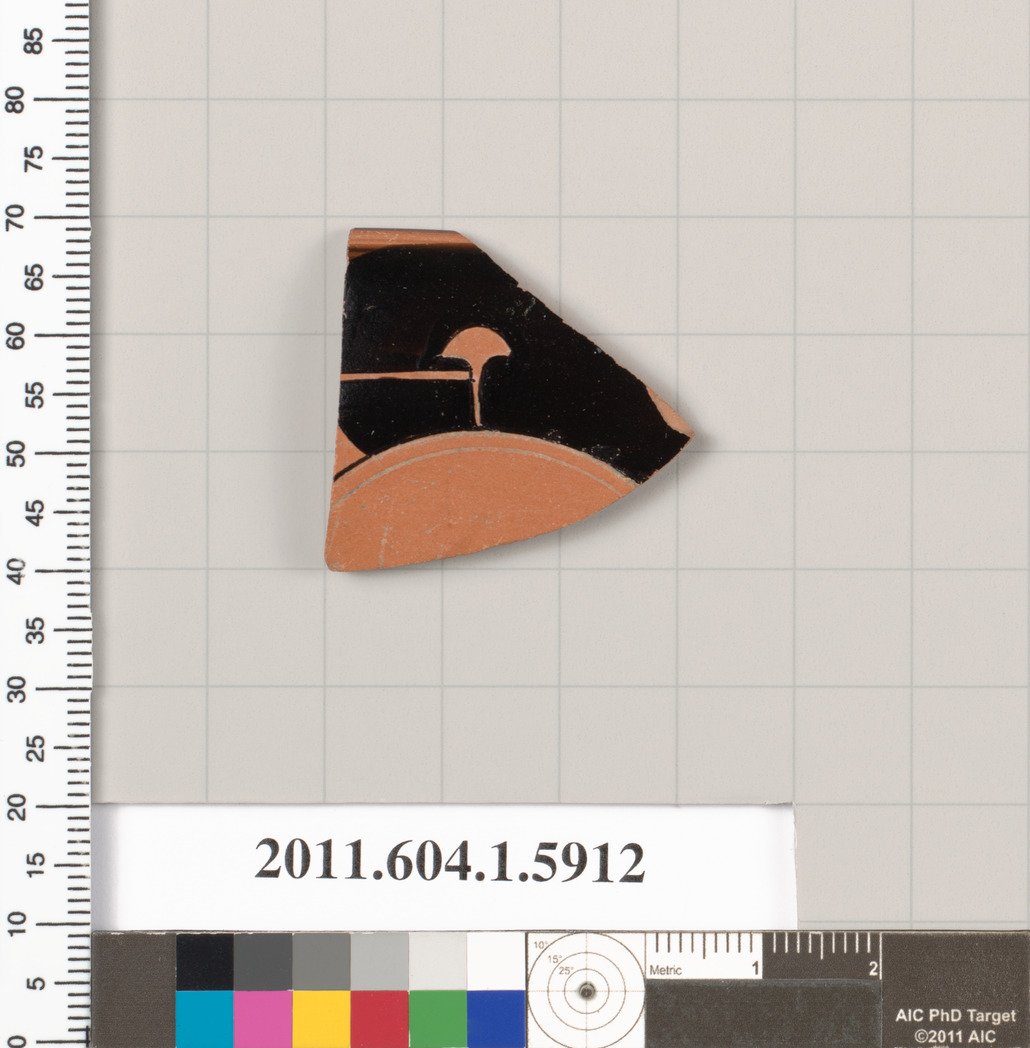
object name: kylix fragment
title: Terracotta rim fragment of a kylix (drinking cup)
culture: greek, attic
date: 520-510 BCE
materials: terracotta